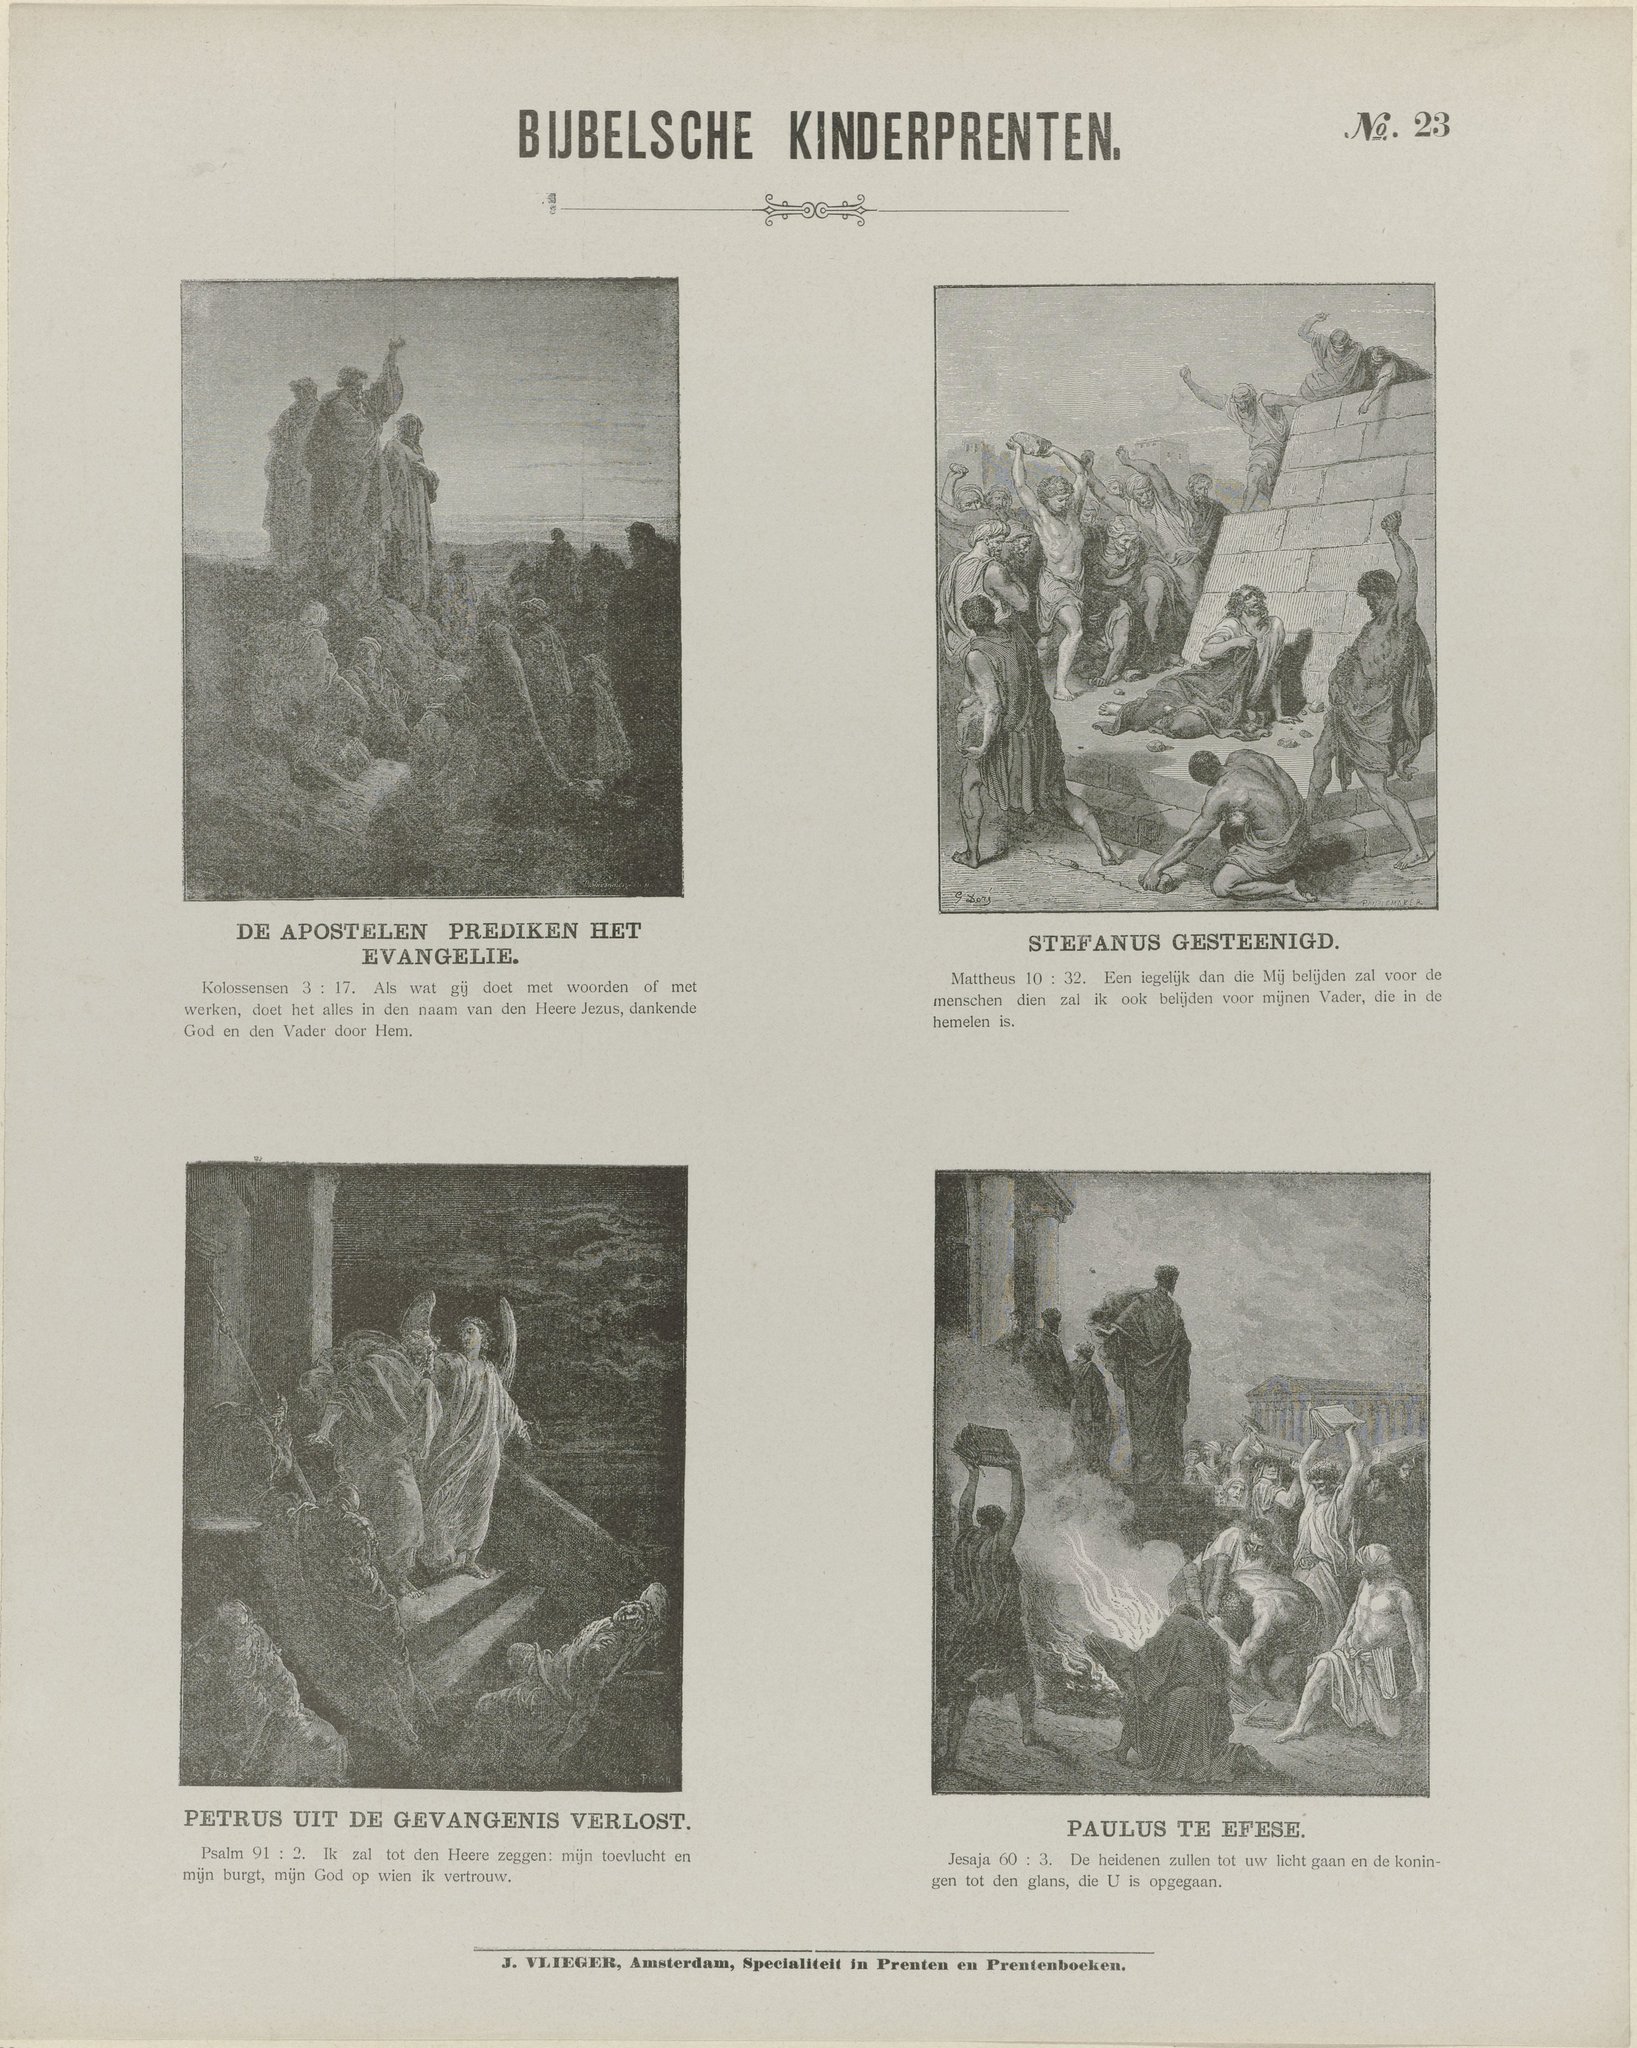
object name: popular print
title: Bijbelsche kinderprenten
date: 1869-1908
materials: paper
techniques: letterpress printing, photoaquatint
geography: amsterdam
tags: the stoning of stephen; the witnesses lay down their clothes at saul's feet, paul preaching in ephesus, new testament, the angel leads peter past the sleeping guards, lives and acts of the apostles of christ; epistles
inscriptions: collector's mark: Lugt 2760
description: Blad met 4 voorstellingen van verhalen uit het Nieuwe Testament. De apostelen prediken het Evangelie, de steniging van Stefanus, de bevrijding van Petrus door de engel en Paulus predikt in Efeze. Onder elke afbeelding een Bijbeltekst. Genummerd rechtsboven: No. 23.